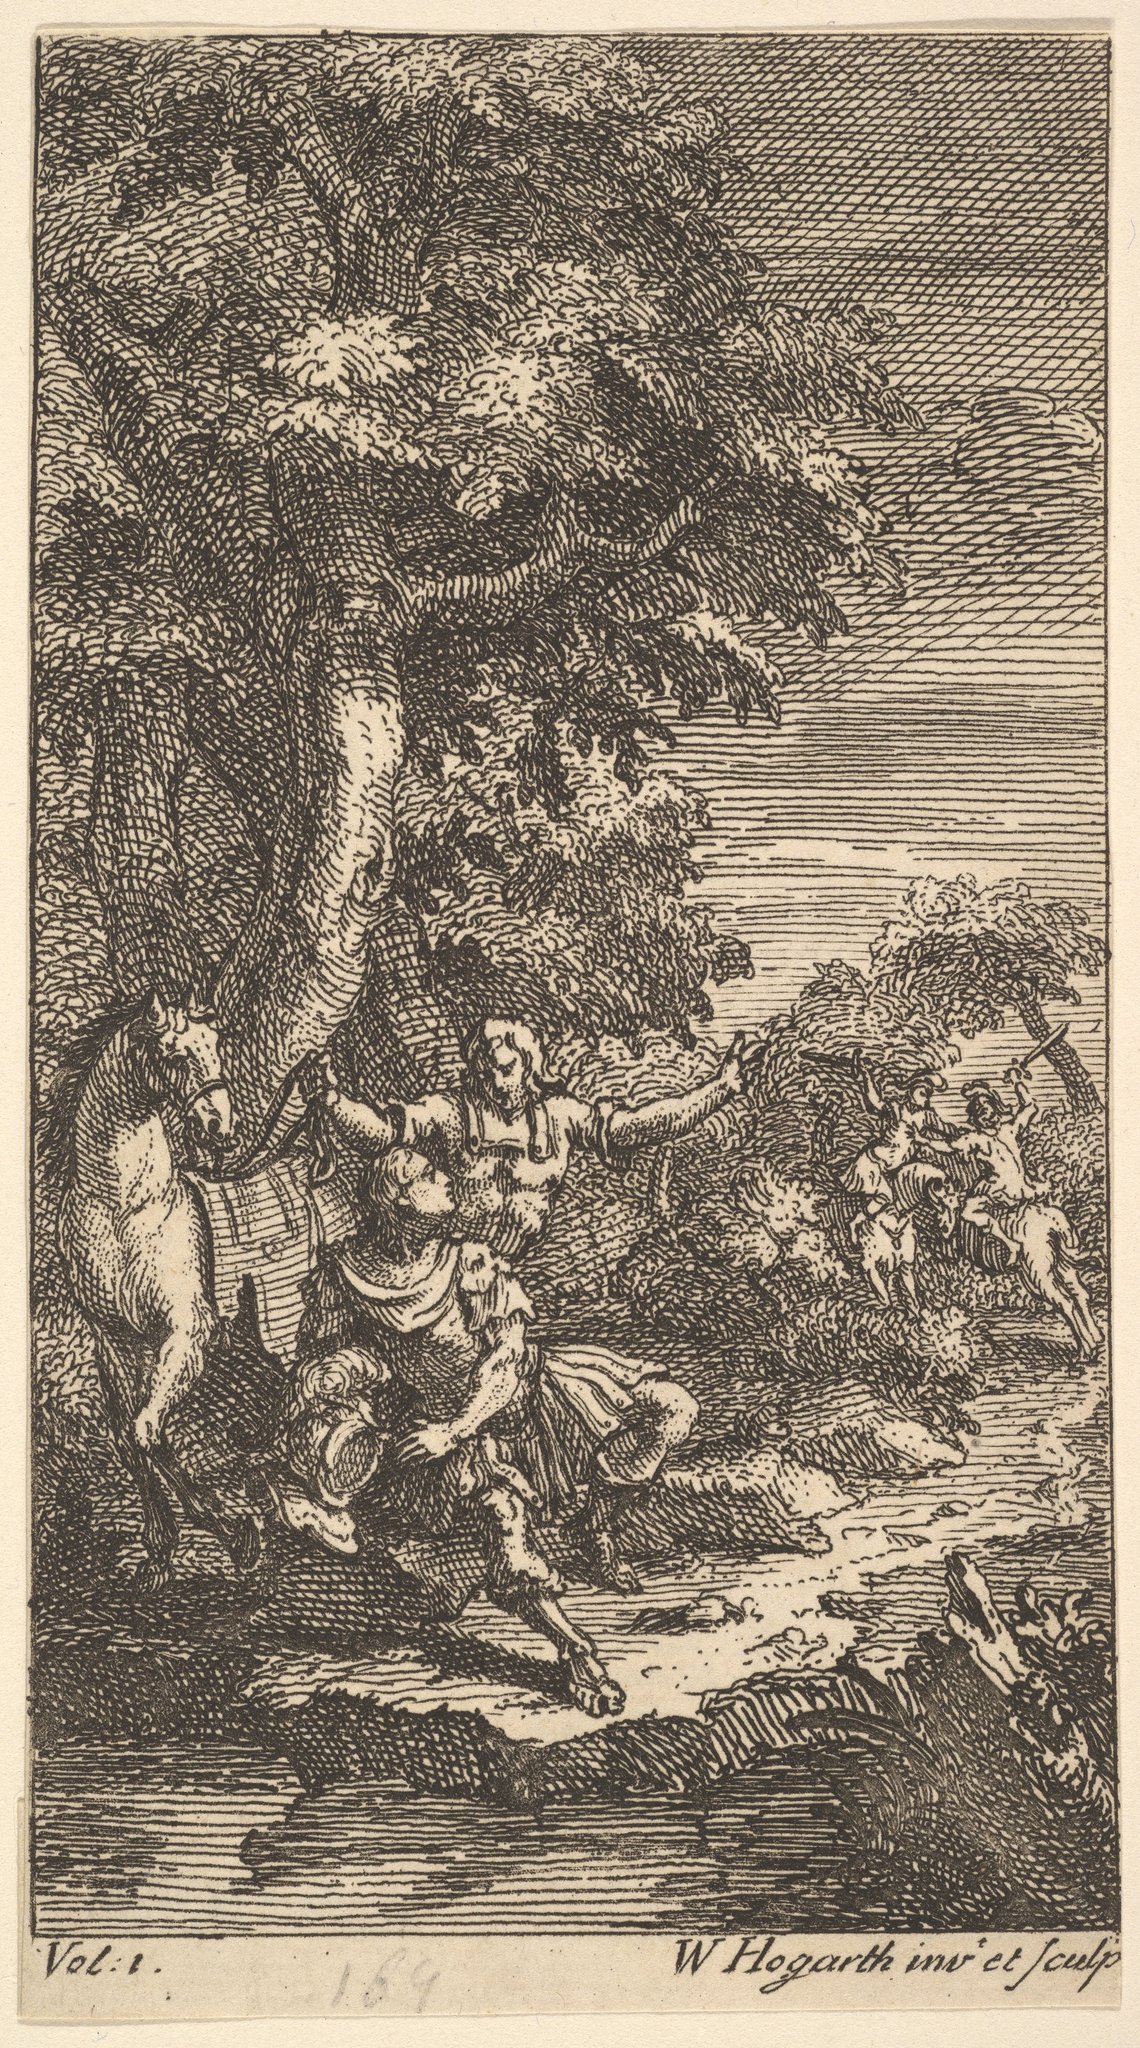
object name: print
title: Cassandra, Frontispiece, Vol. 1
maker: william hogarth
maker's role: artist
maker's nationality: british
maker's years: 1697-1764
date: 1725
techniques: engraving, etching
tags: men,horses